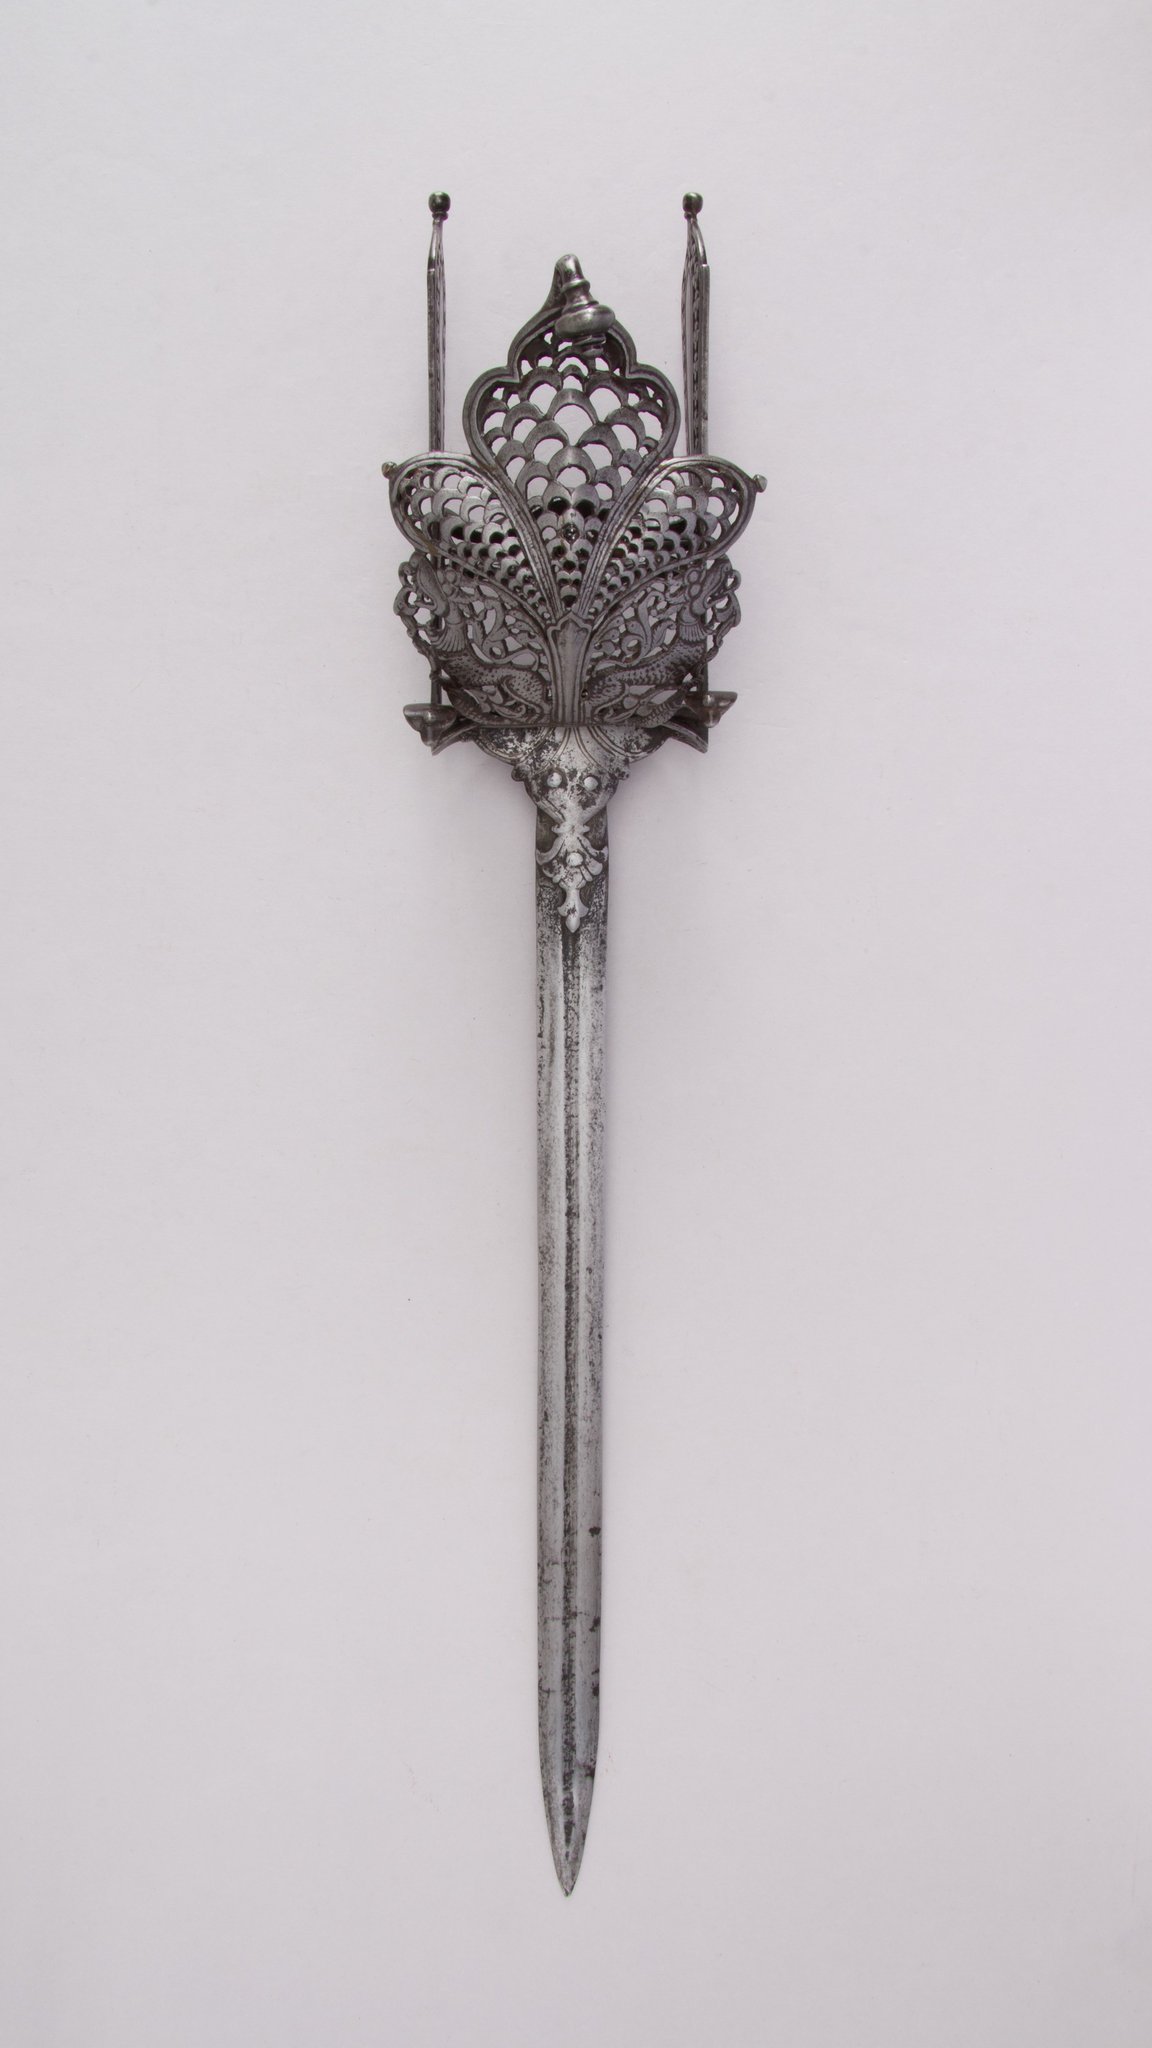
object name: dagger katar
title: Guarded Dagger (Katar)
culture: indian or european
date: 1501-1600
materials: steel